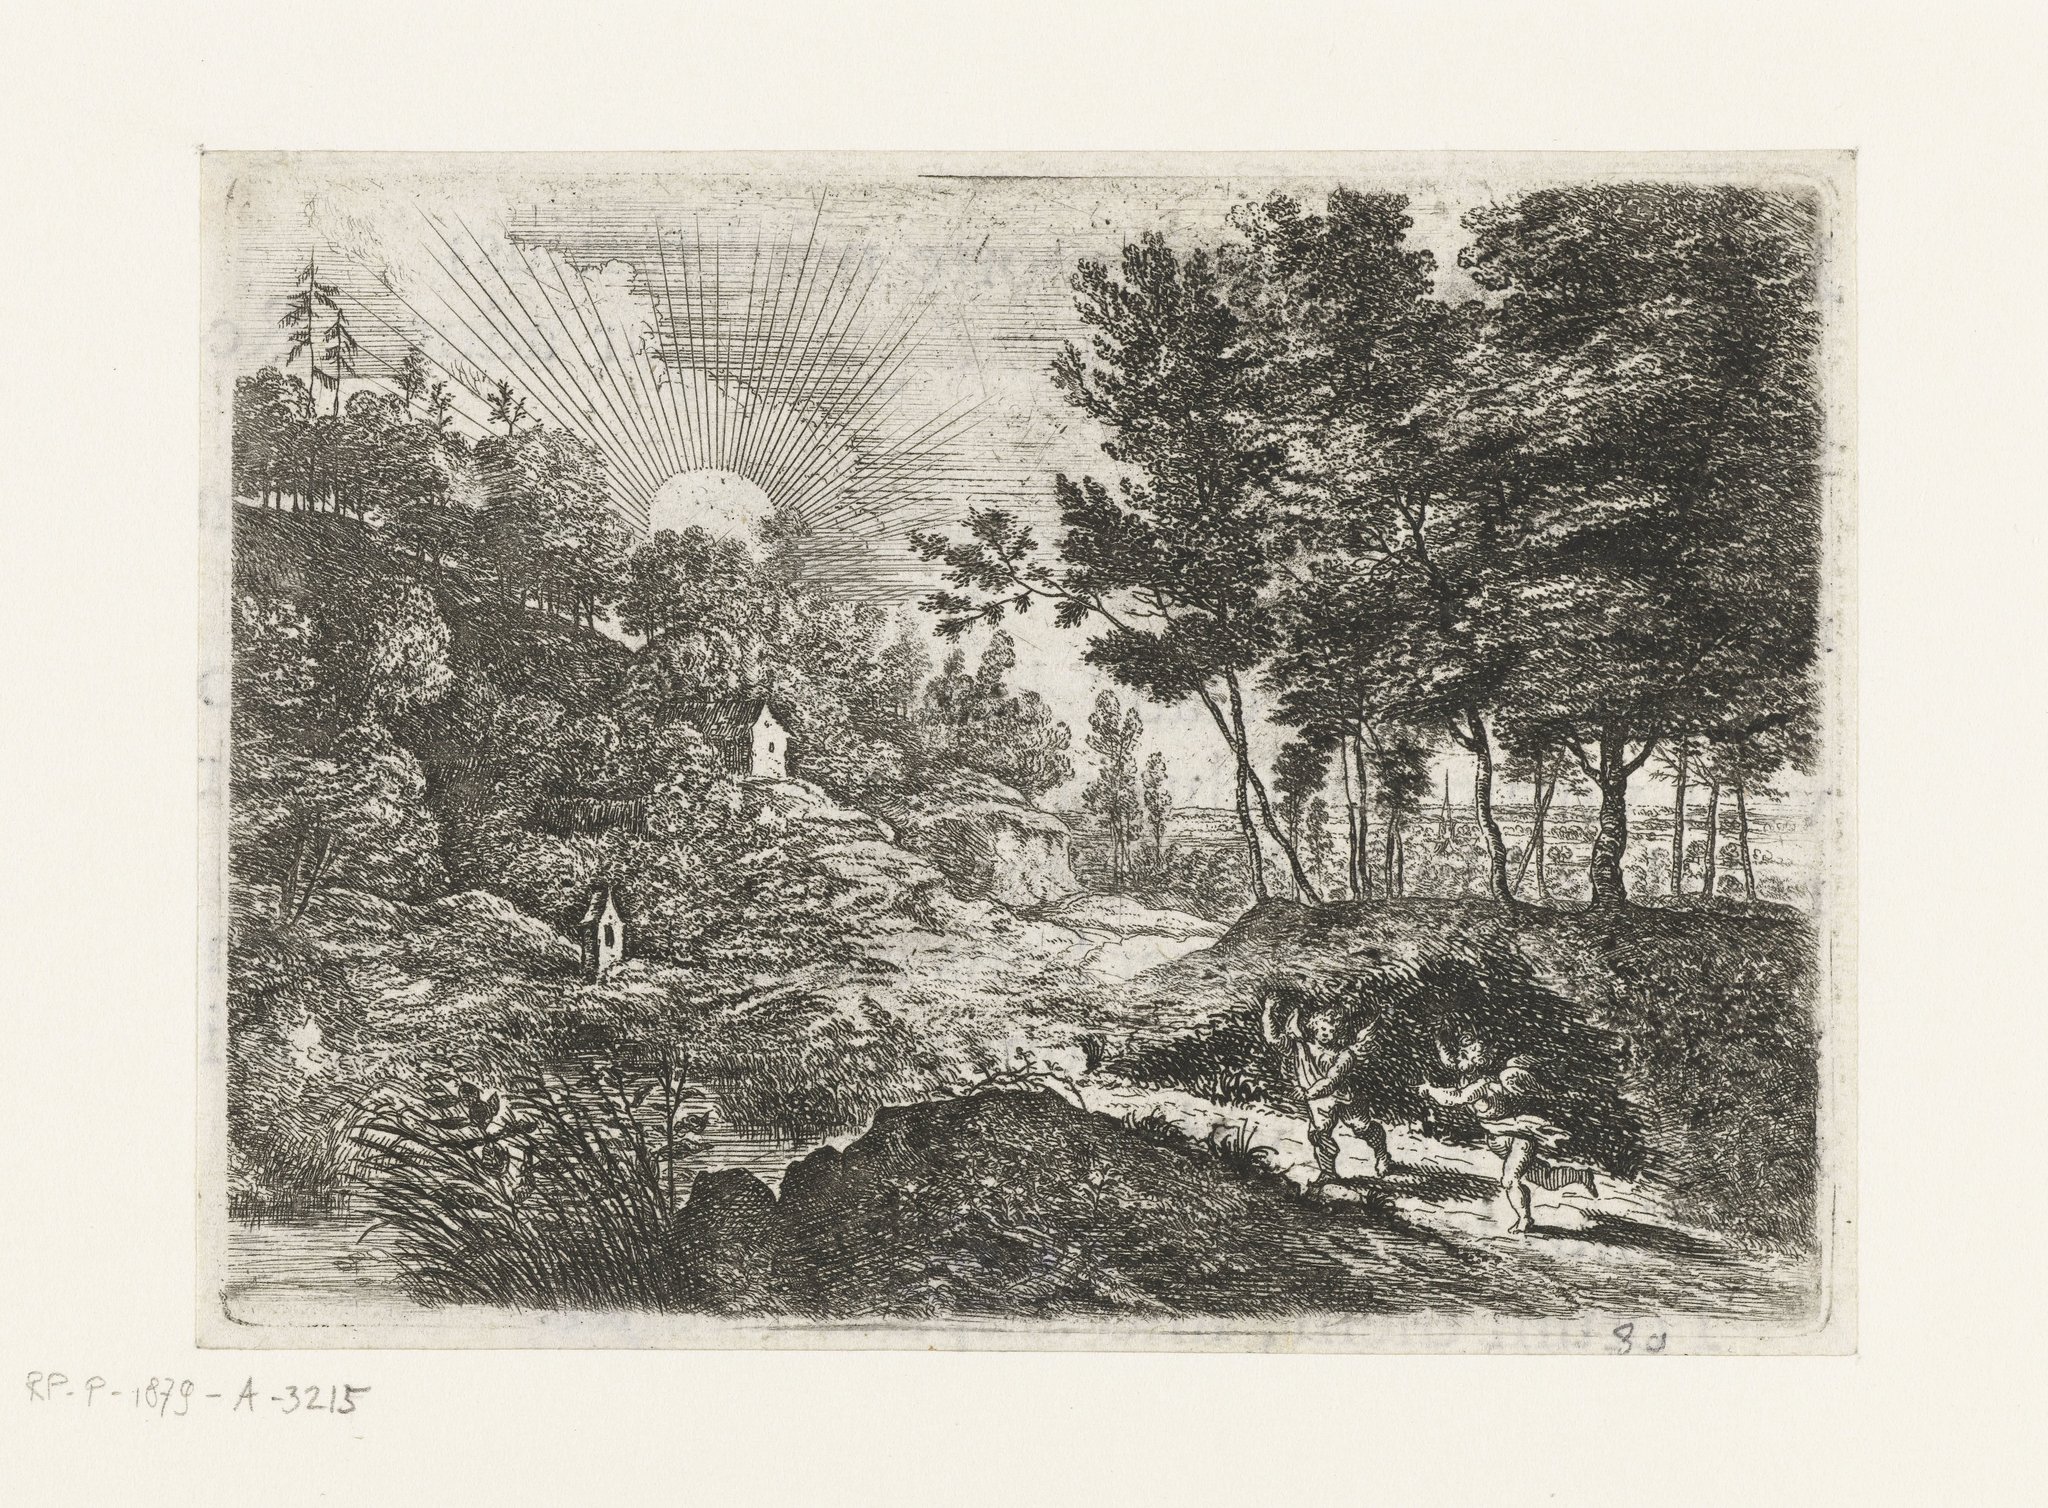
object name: book illustration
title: Landschap met twee putti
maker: lucas van uden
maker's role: draughtsman, print maker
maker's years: 1595-1673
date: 1605-1673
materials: paper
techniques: engraving, etching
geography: low countries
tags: landscapes in the temperate zone, sunset, cupids: 'amores', 'amoretti', 'putti'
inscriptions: collector's mark: Lugt 2228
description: Gebruikt als boekillustratie. De ondergaande zon is toegevoegd aan de oorspronkelijke voorstelling. Een zittende man, een jongen en een vrouw met een kruik zijn vervangen door twee rennende putti.